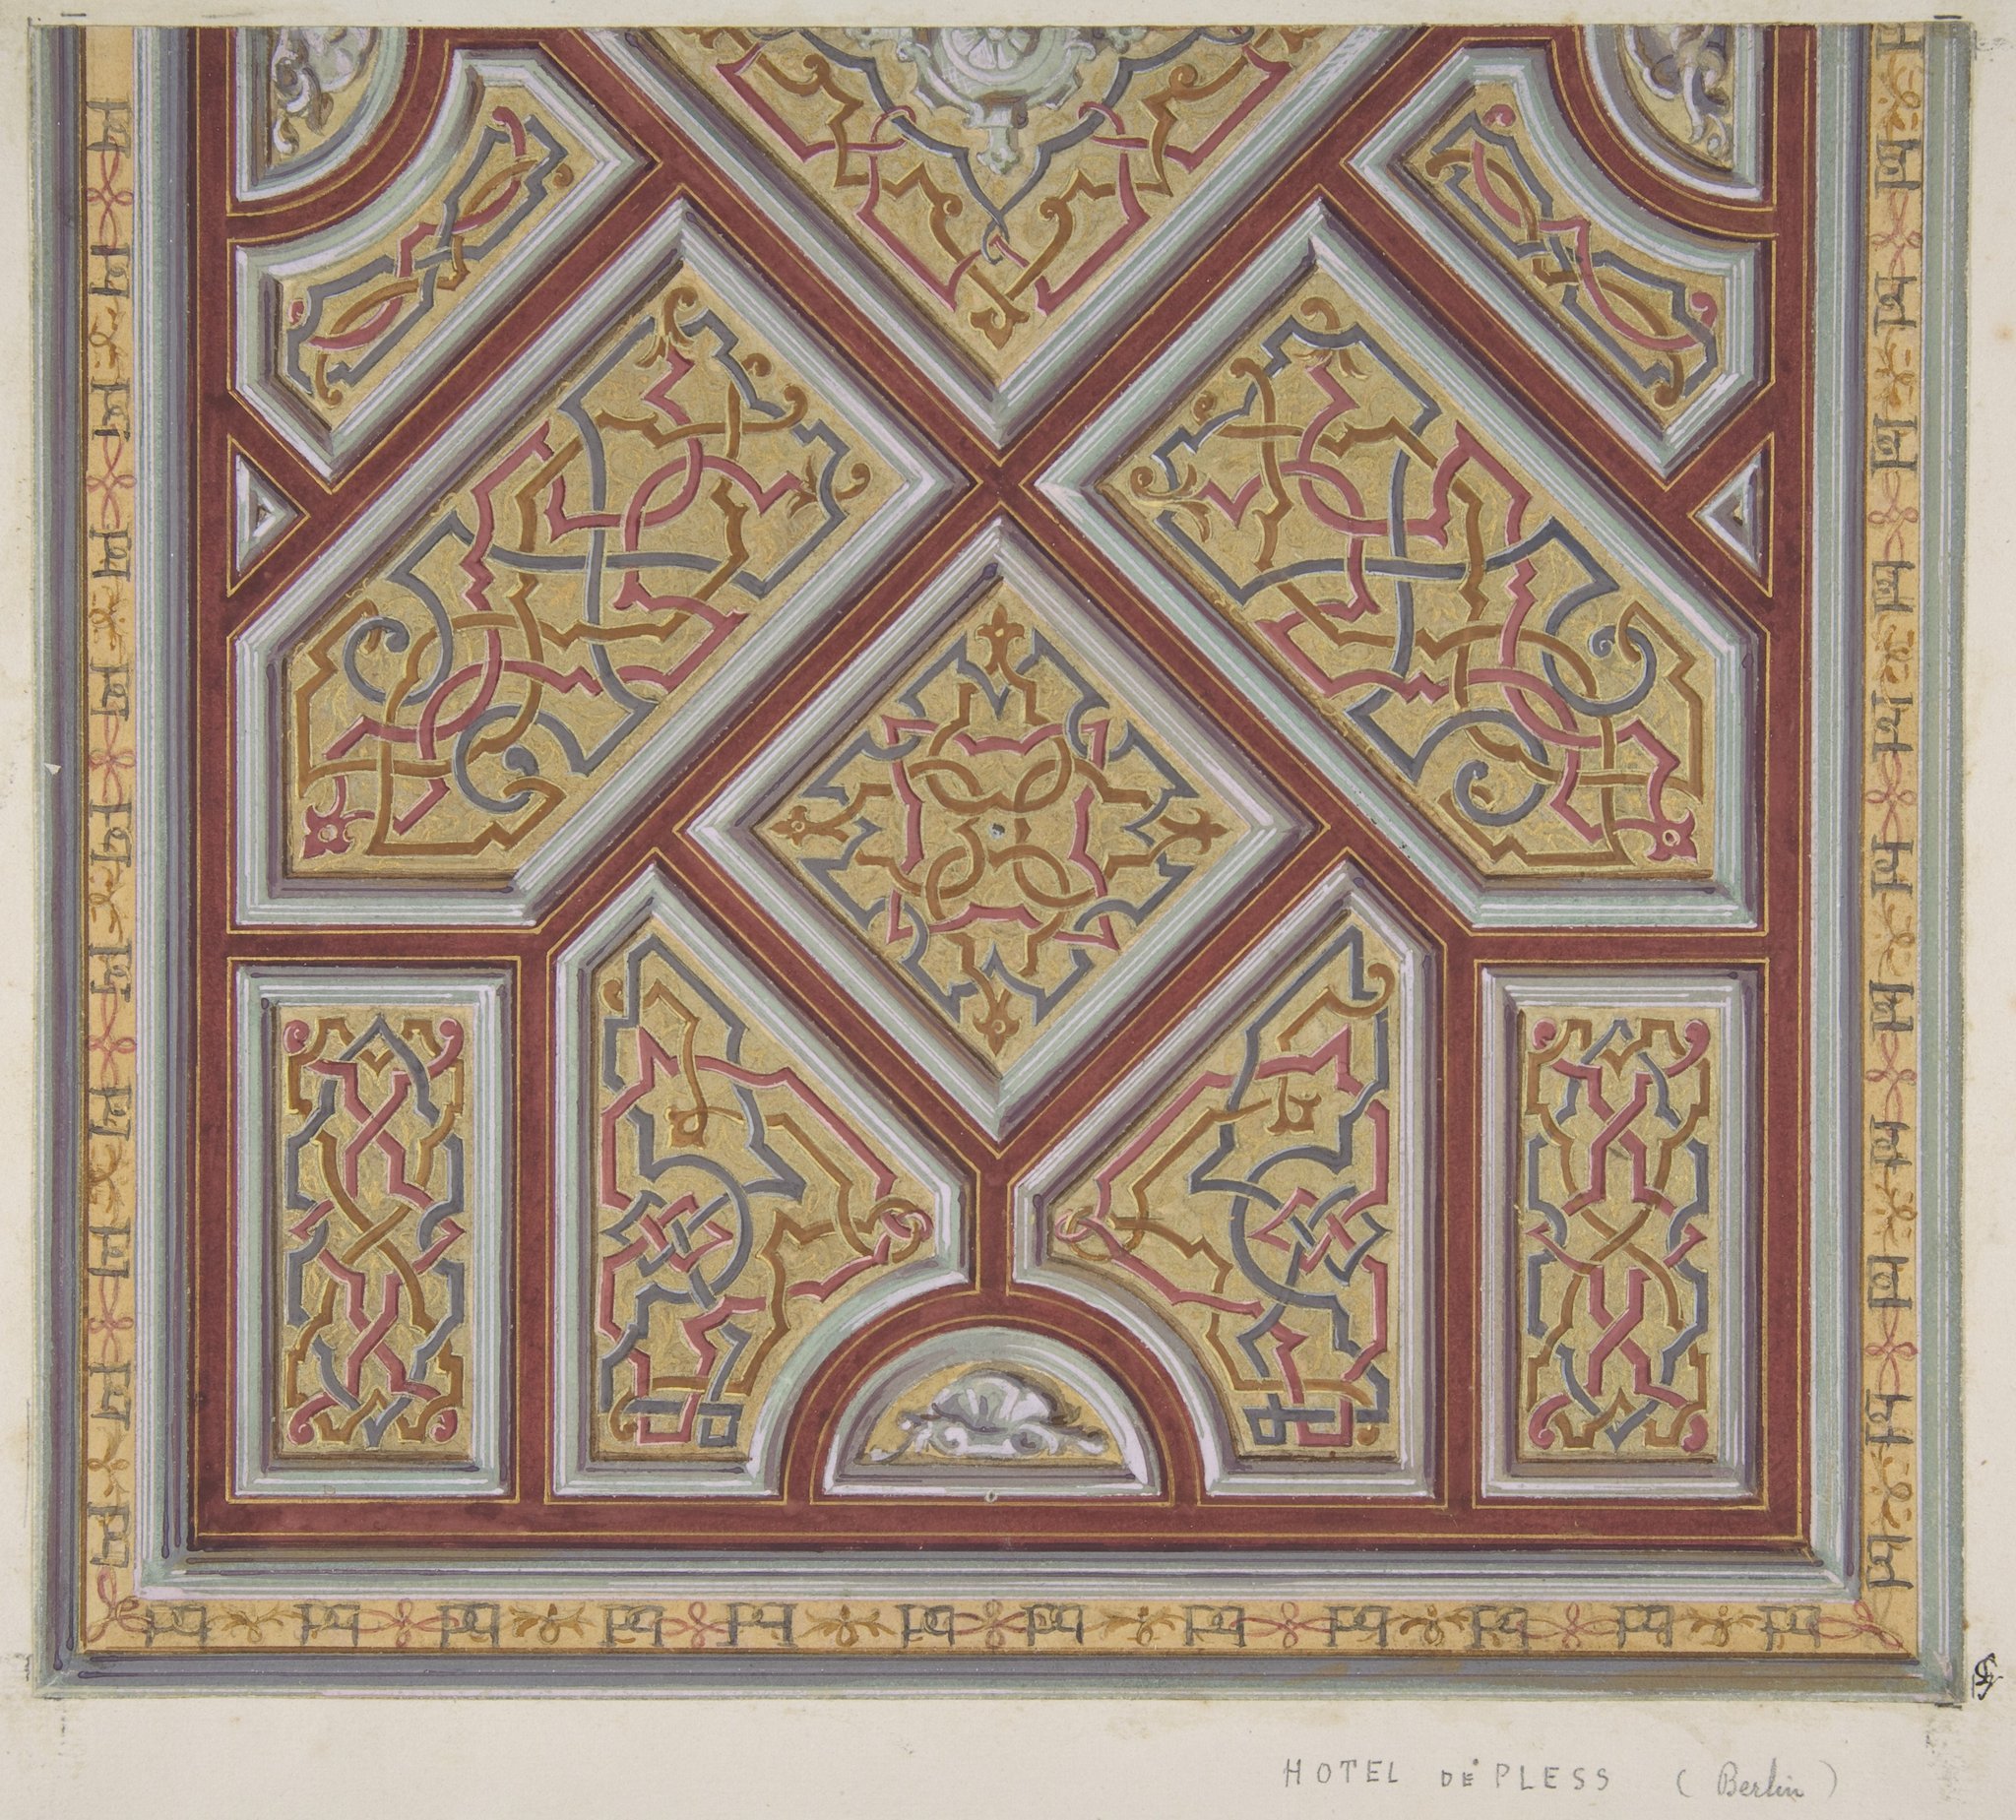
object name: drawing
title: Design for Ceiling Decoration in the Hôtel de Pless, Berlin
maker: jules-edmond-charles lachaise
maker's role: artist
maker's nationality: french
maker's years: 1897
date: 1851-1900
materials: gold paint, gouache, watercolor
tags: ceilings